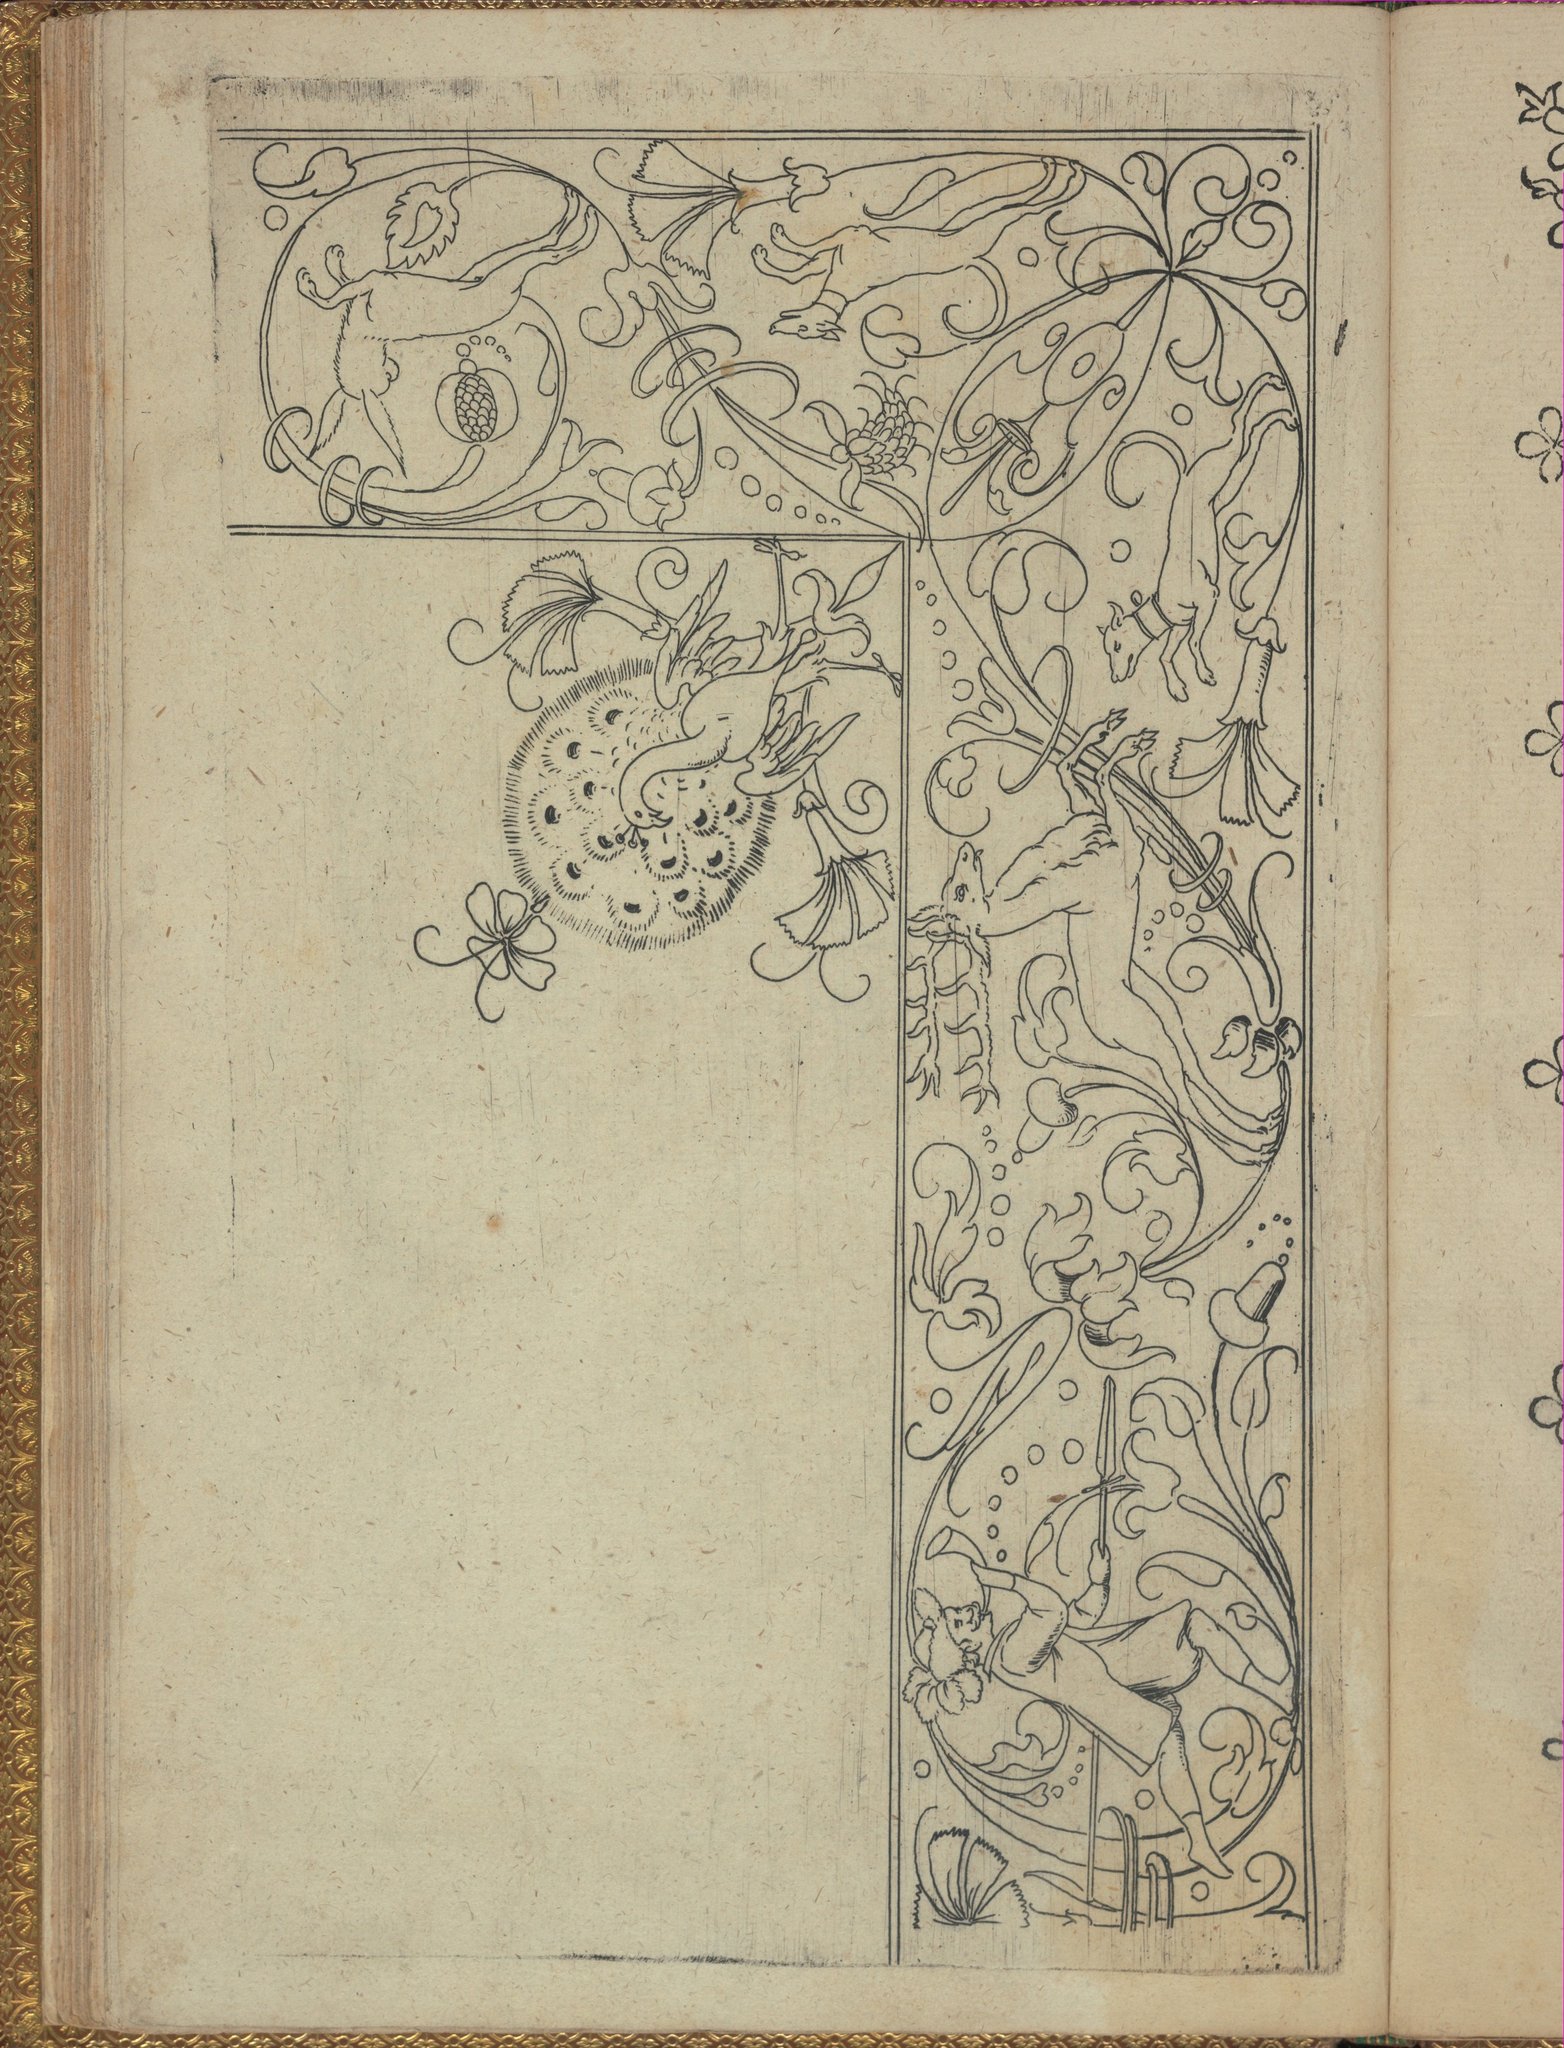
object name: book print ornament architecture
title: New Modelbüch (Page 49r)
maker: andreas bretschneider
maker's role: designer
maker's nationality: german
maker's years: 1573-1645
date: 1615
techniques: woodcut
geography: germany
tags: animals,ornament,men